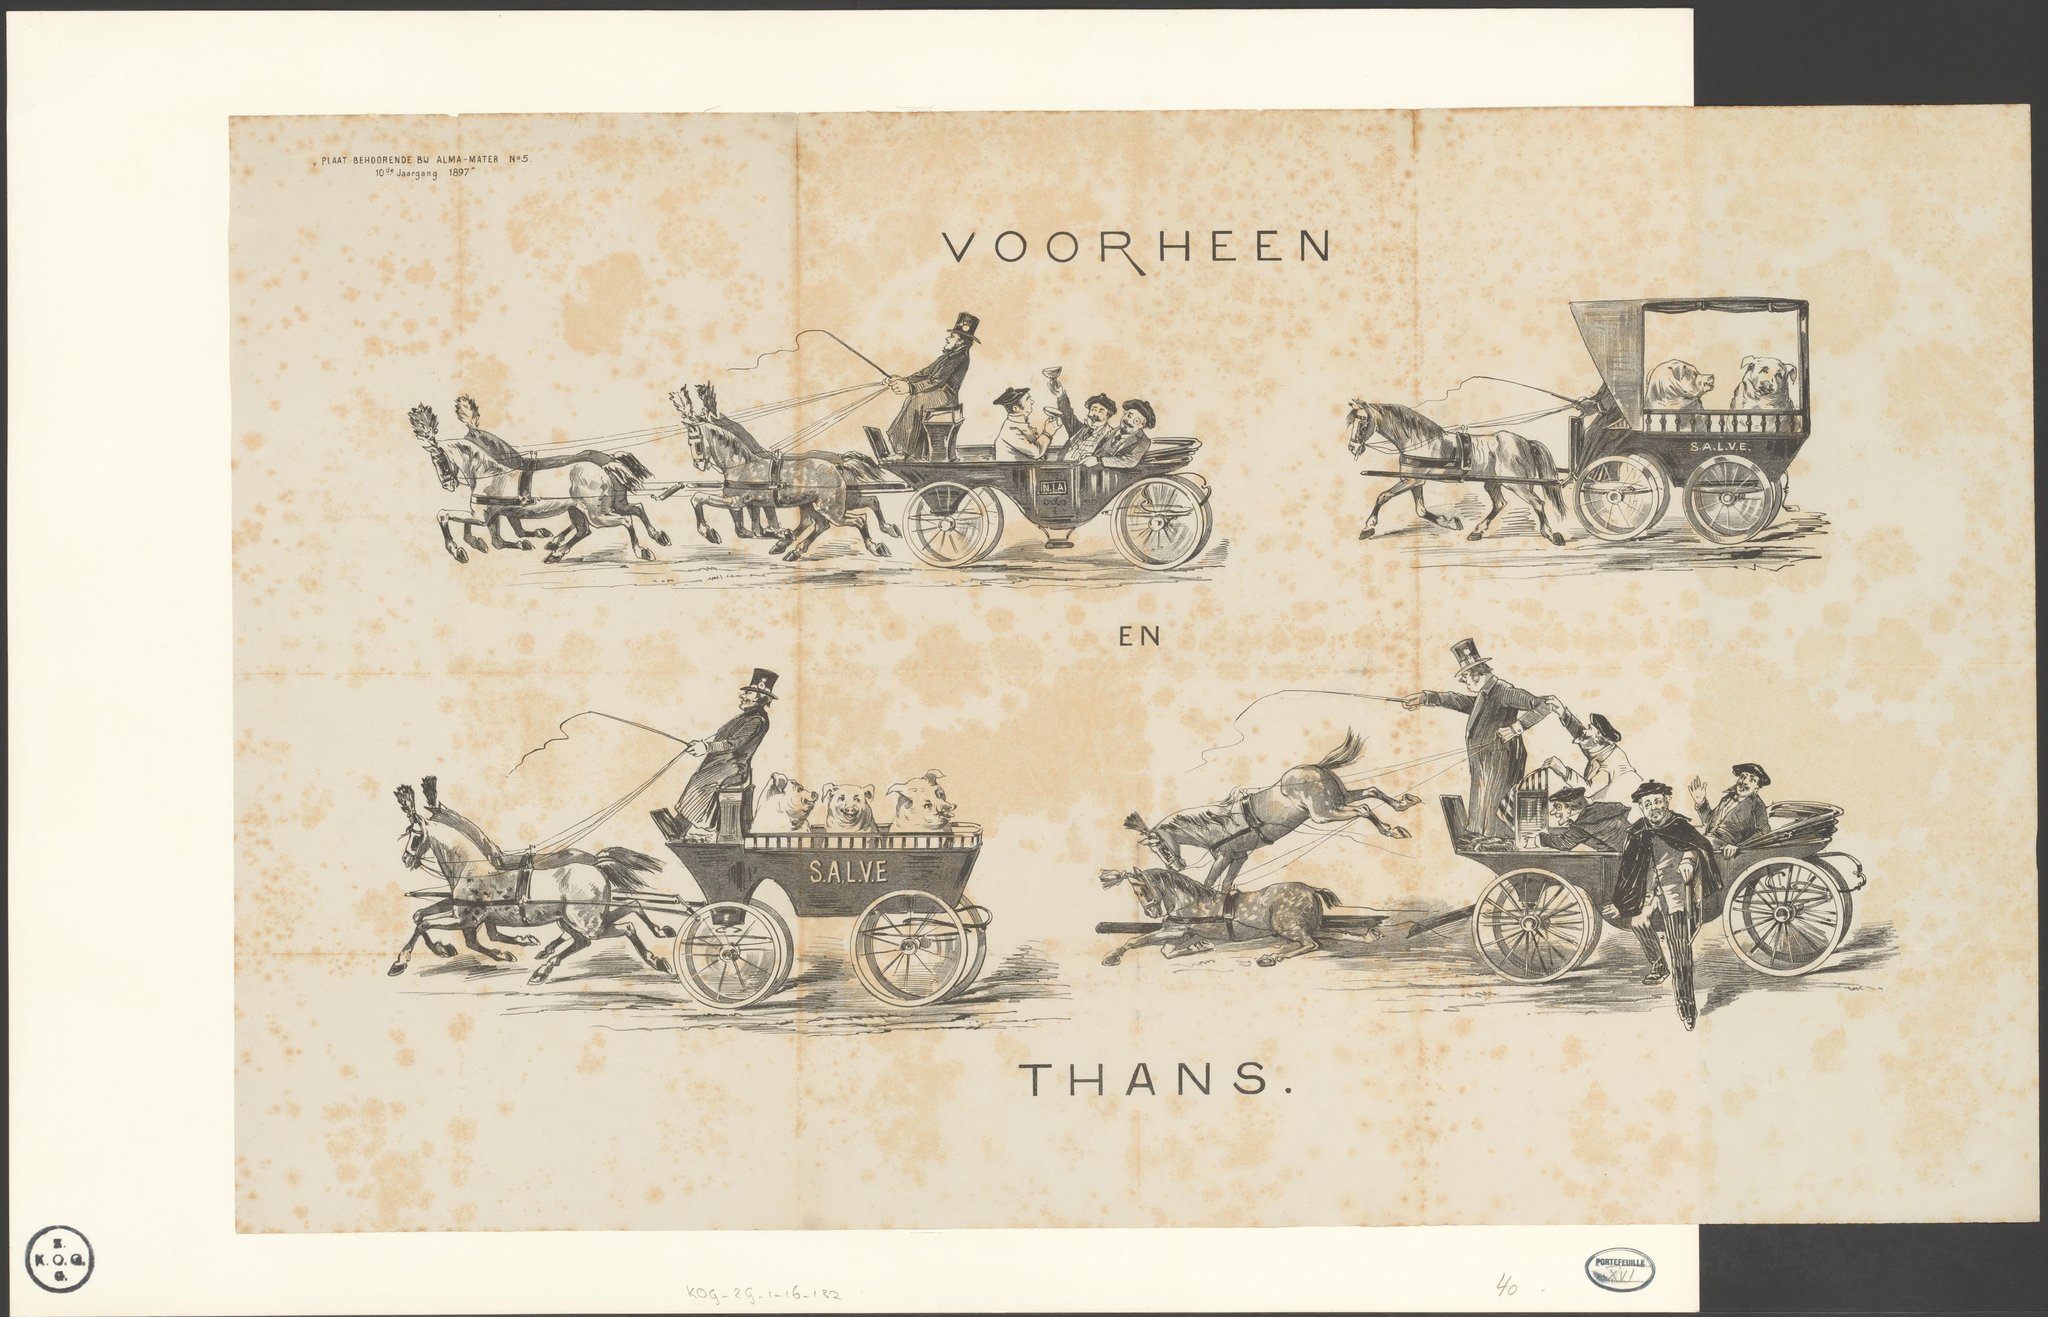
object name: print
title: Voorheen en thans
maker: Anonymous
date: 1897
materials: paper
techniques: lithograph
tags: two-wheeled, animal-drawn vehicle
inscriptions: collector's mark: Lugt 1641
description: Twee rijen met steeds twee koetsen. Bovenaan het woord Voorheen met eronder vooraan een koets, getrokken door vier paarden. In de koets zitten drie mannen met champagnecoupes. Op de koets staat N.I.A. In de achterste kleinere koets zitten twee varkens. Op deze koets de letters S.A.L.V.E. Onderaan Rijdt de wagen met de varkens vooraan en de varkens kijken naar de koets achter hen. De paarden van de koets van de mannen zijn gevallen en de koets is gebroken. Een man staat naast de koets. Onderwerpsrubrieken binnen de Atlas Zeden en Gewoonten: Onderwijs en Wetenschappen, Studentenleven.